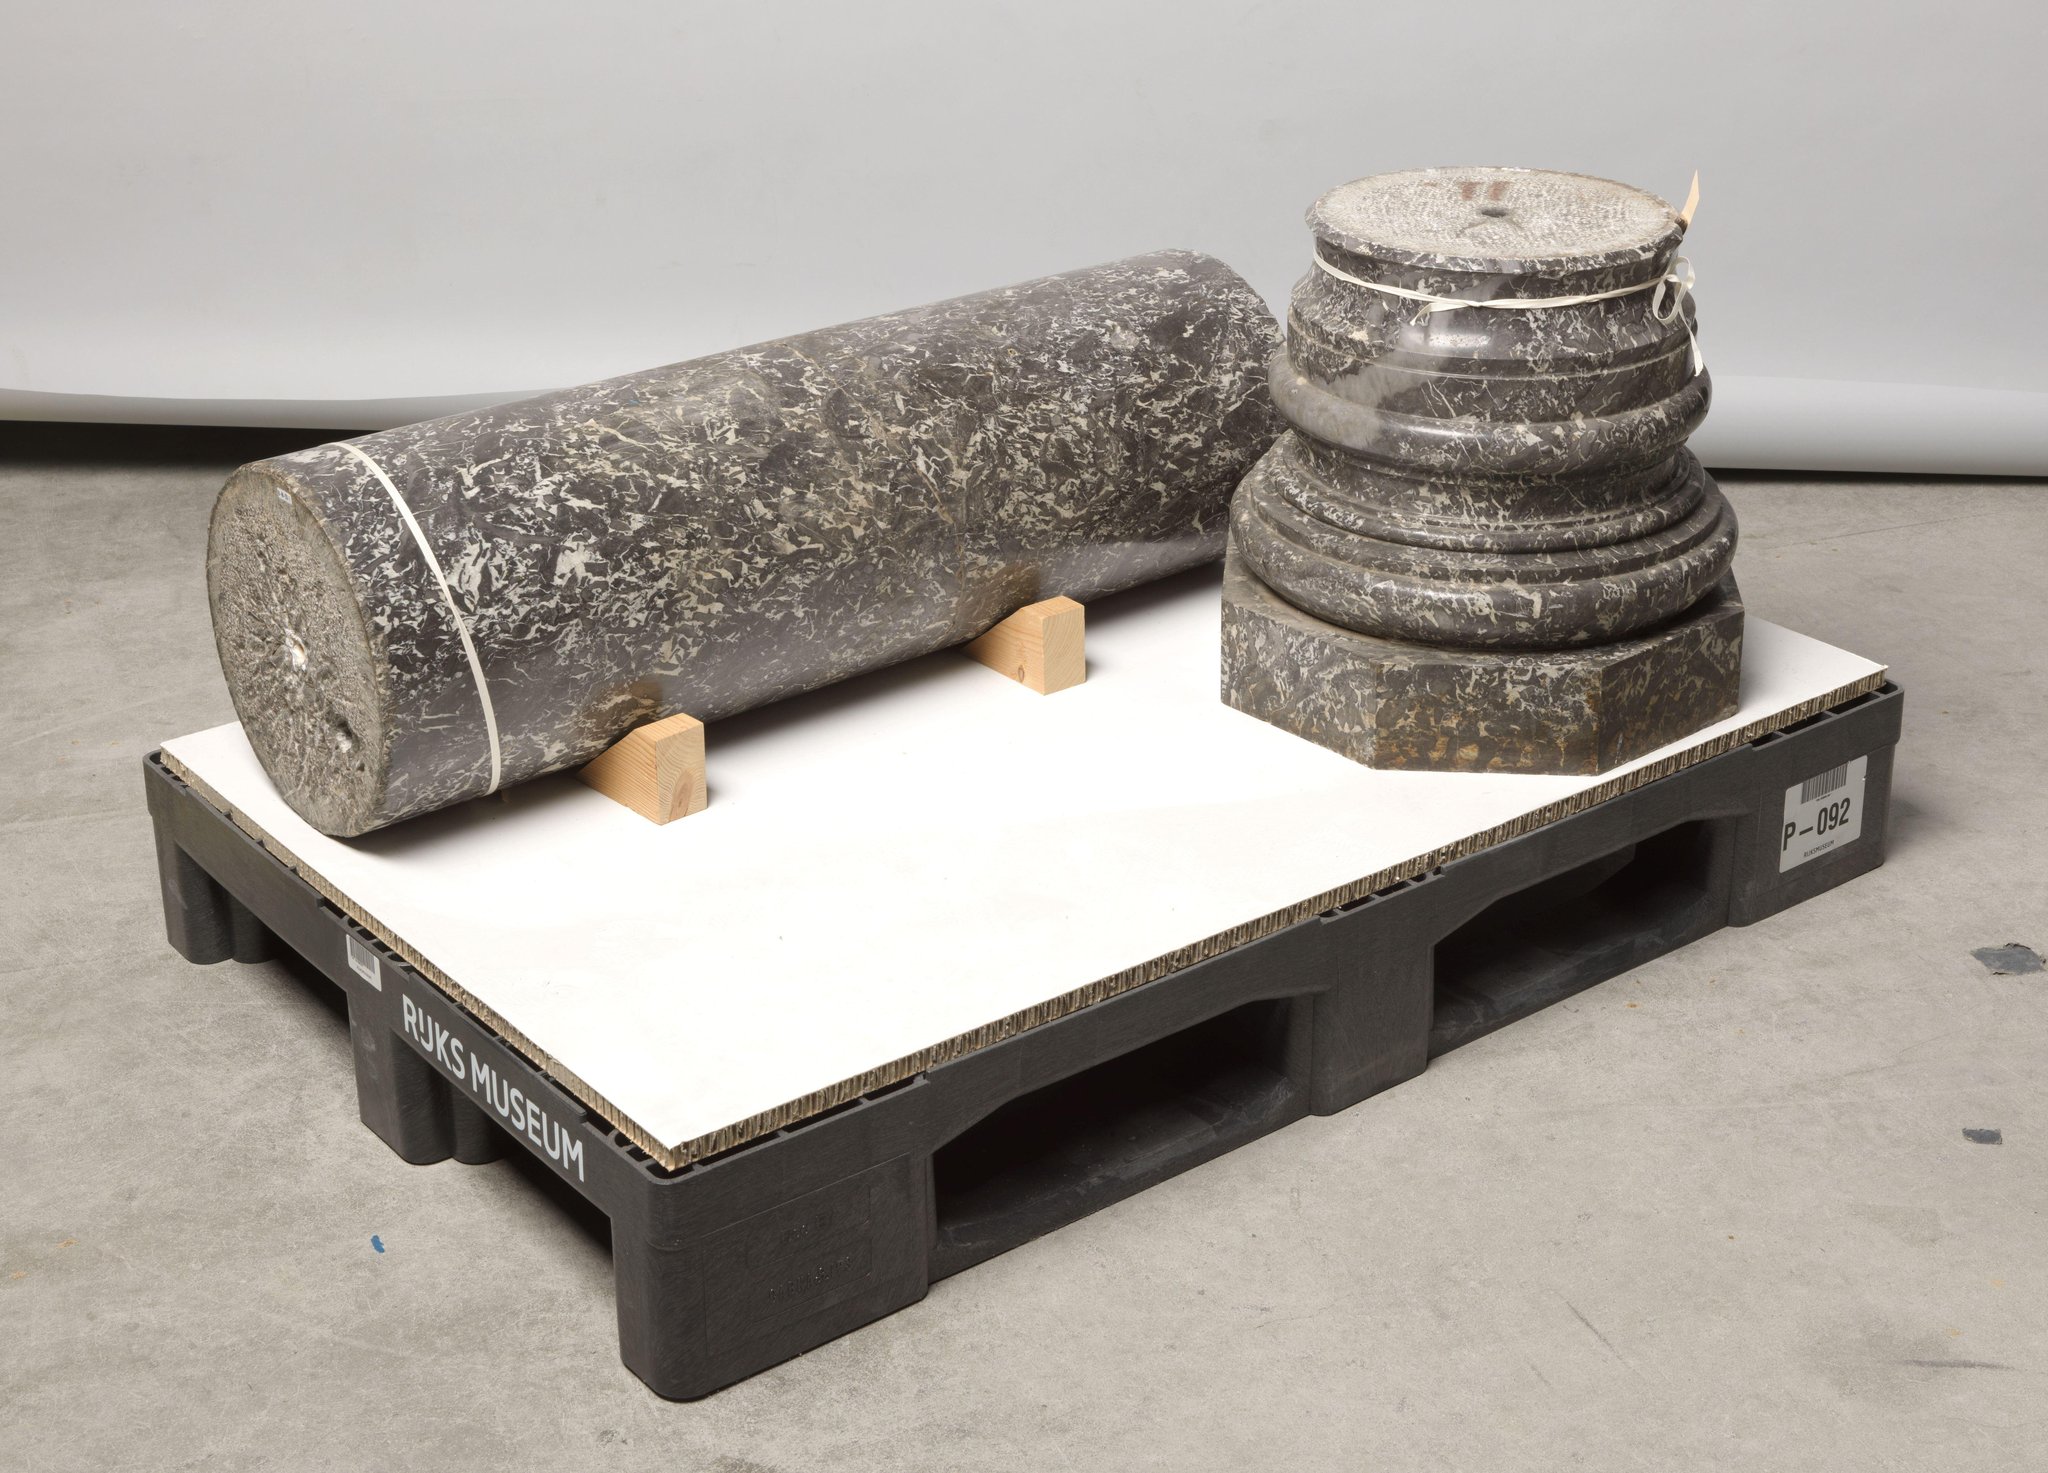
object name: base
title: Cilindrische schacht van Belgisch Saint-Anne marmer, behorend bij Buste van Karel II, kroonprins van Engeland (1630-1685)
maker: Anonymous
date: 1900-1950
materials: marble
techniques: carved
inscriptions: annotation: ‘11.’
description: Cilindrische schacht van grijs, zwart en wit geaderd gepolijst marmer, behorend bij 'Buste van Karel II, kroonprins van Engeland (1630-1685)'. Het bovenblad is ruw afgewerkt en bevat twee penopeningen. Op de schacht zijn twee gaten voor een plaatje aangebracht. Het rijkelijk gedecoreerde vergulde koperen plaatje ontbreekt (zie tabblad opmerkingen). Op het vergulde koperen plaatje staat het opschrift: Karel van Engeland toegeschreven aan ROMBOUT VERHULST 2E HELFT 17E EEUW. De onderzijde is vlak en geheel gepolijst en bevat een annotatie. De schacht is gelijk aan NG-761-2.